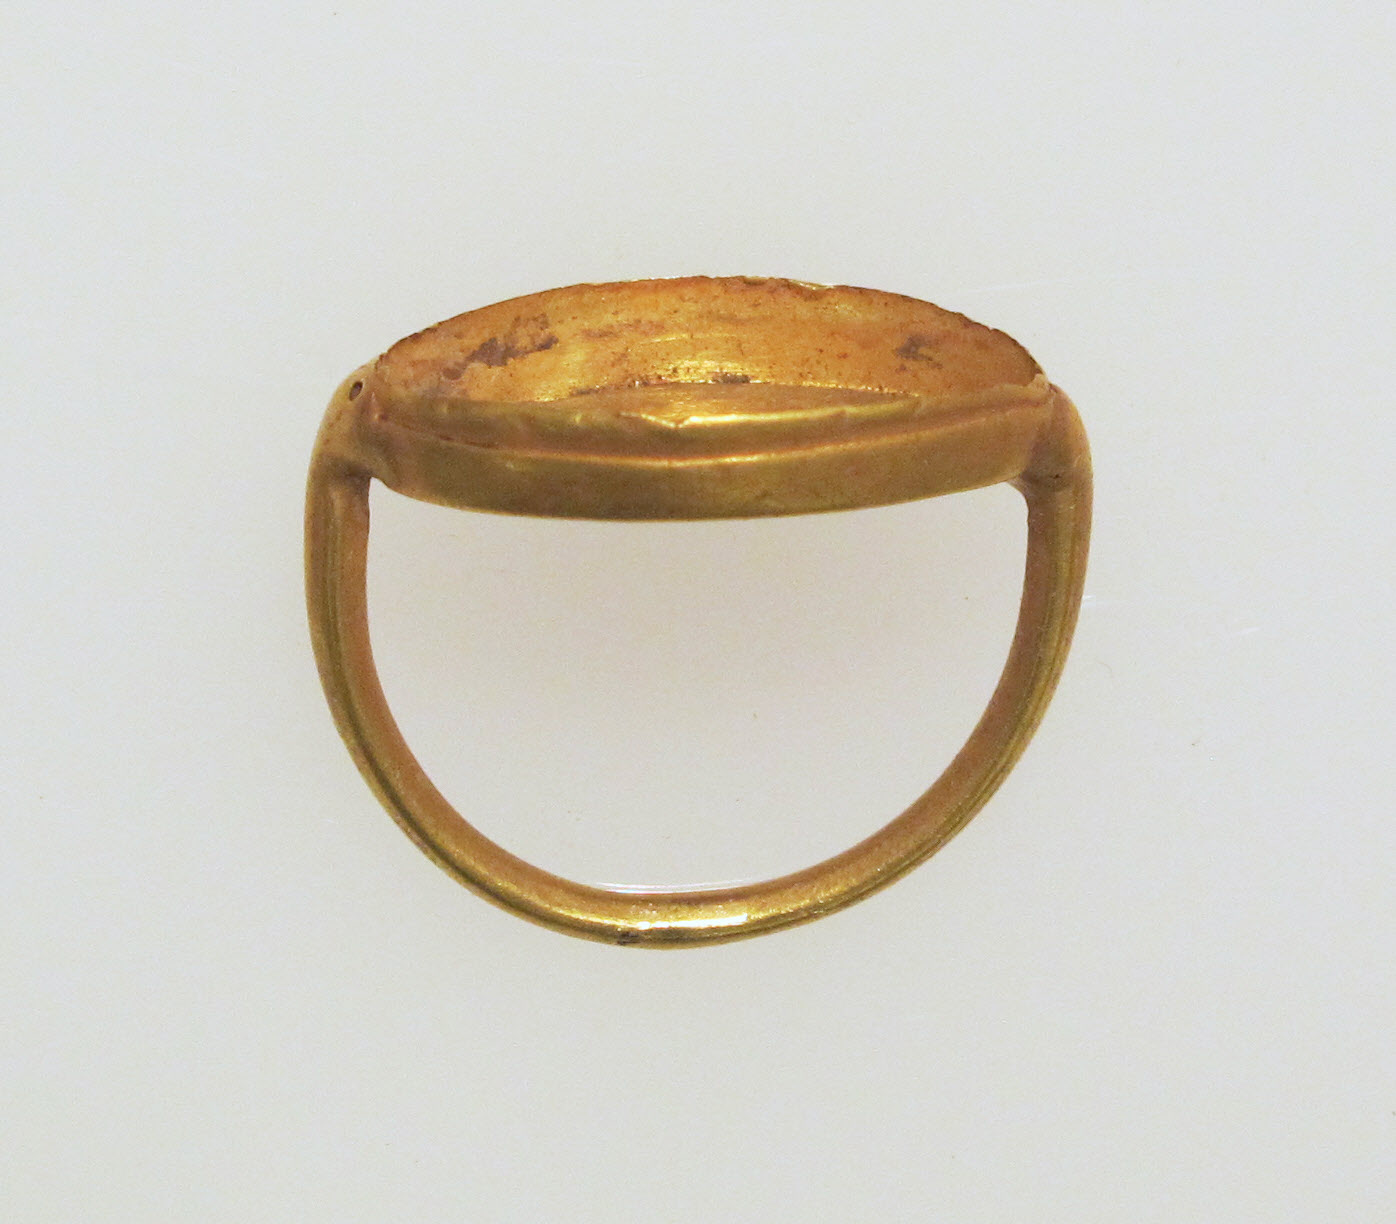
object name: ring with box setting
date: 7000 BCE-330 CE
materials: gold